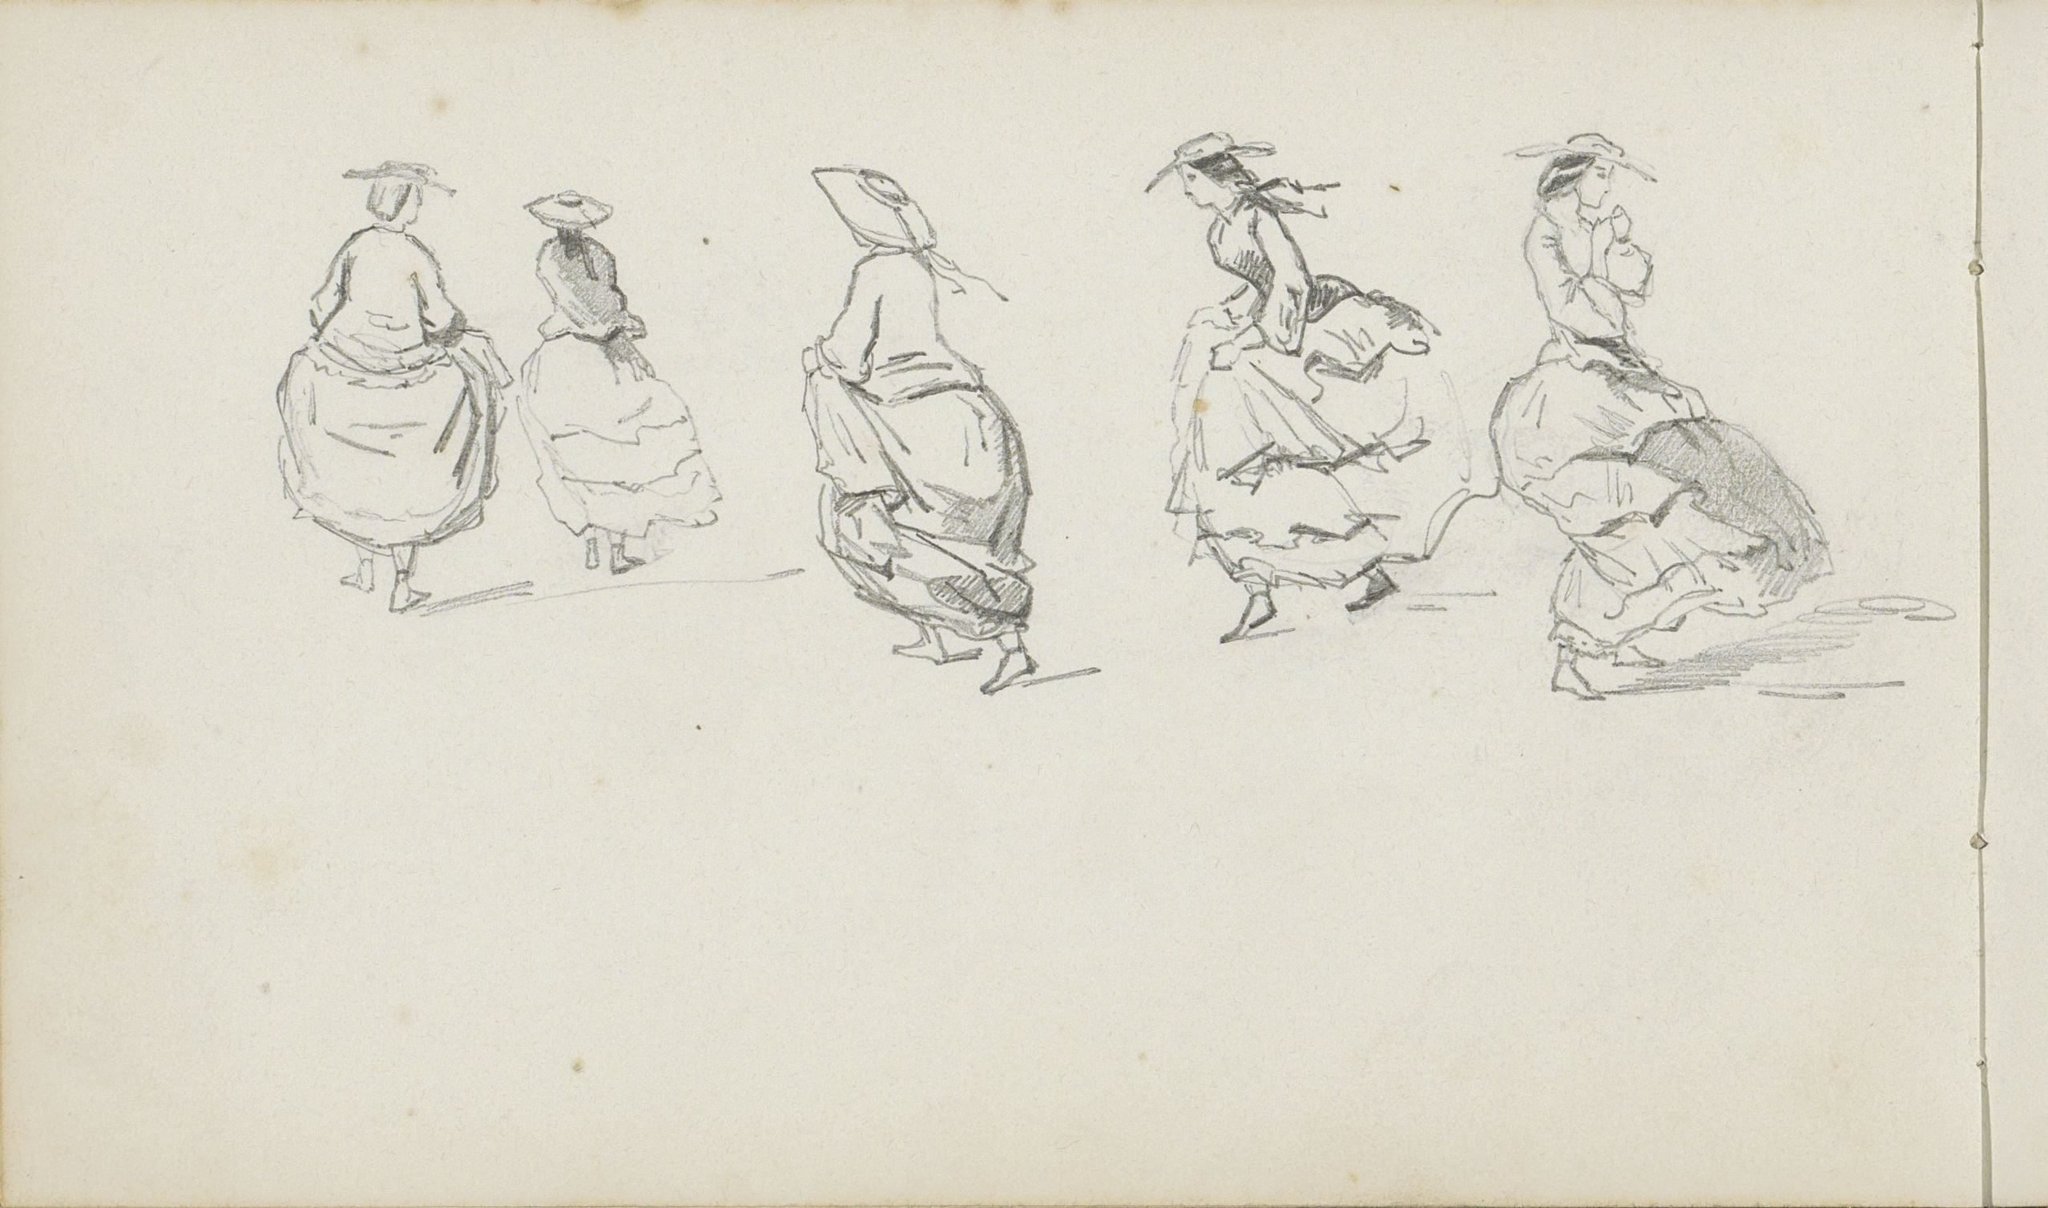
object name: sketchbook leaf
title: Wandelende vrouwen met opgetrokken rokken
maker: charles rochussen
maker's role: draughtsman, painter, print maker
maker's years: 1814-1894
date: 1840-1860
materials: paper, pencil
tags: walking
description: Blad 10 verso uit een schetsboek met 38 bladen.